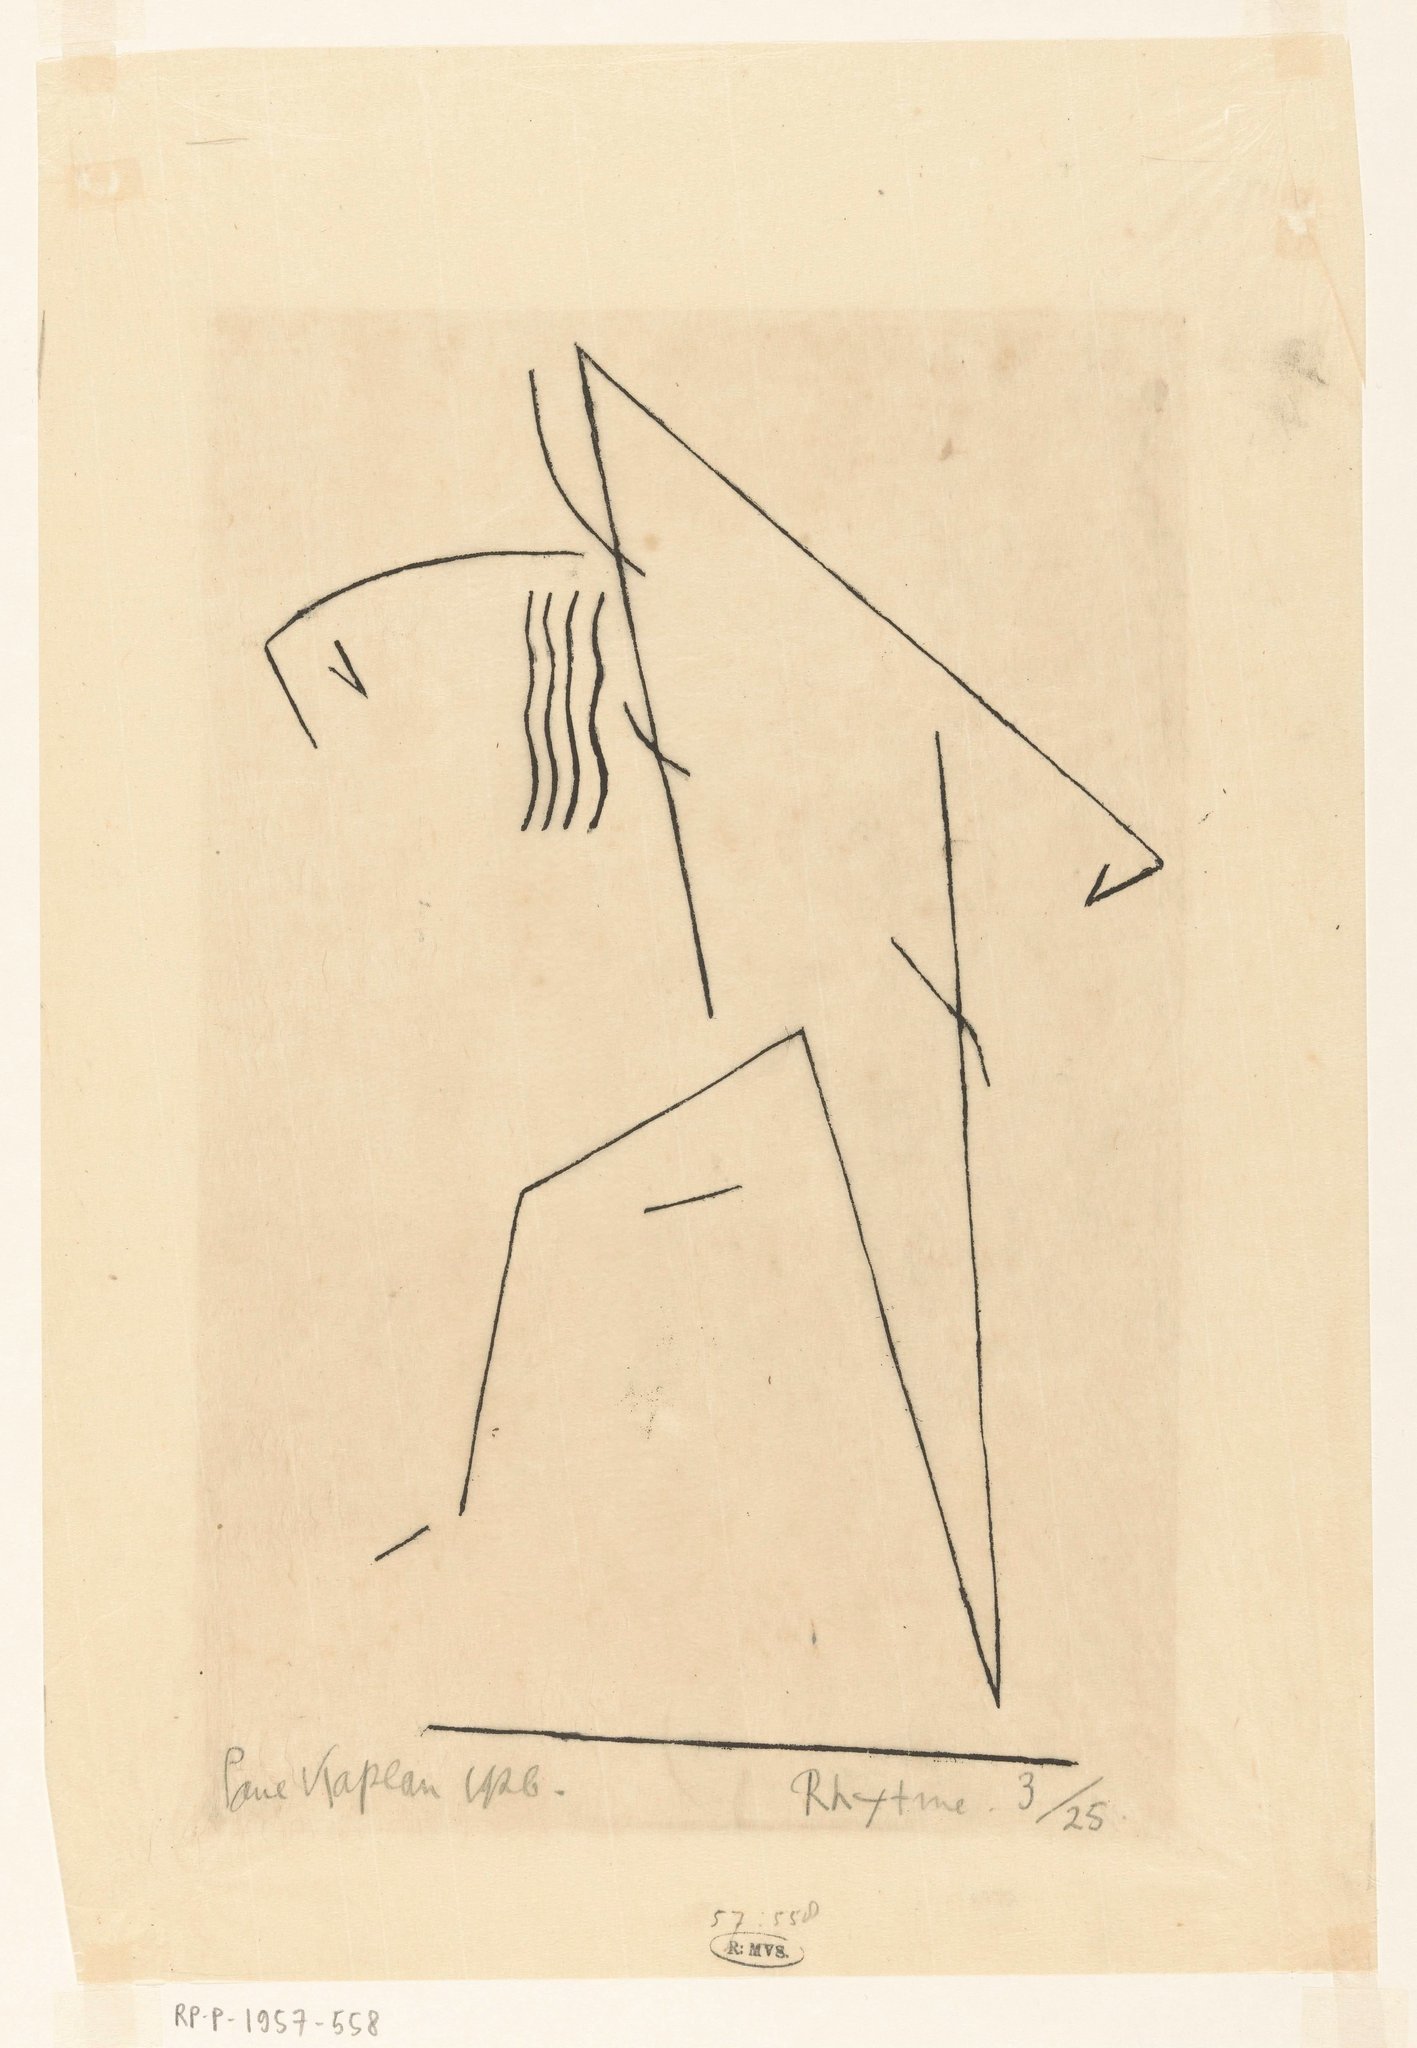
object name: print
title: Rythme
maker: paul kaplan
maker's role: print maker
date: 1926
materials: paper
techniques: lithograph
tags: dancing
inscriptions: collector's mark: Lugt 2228